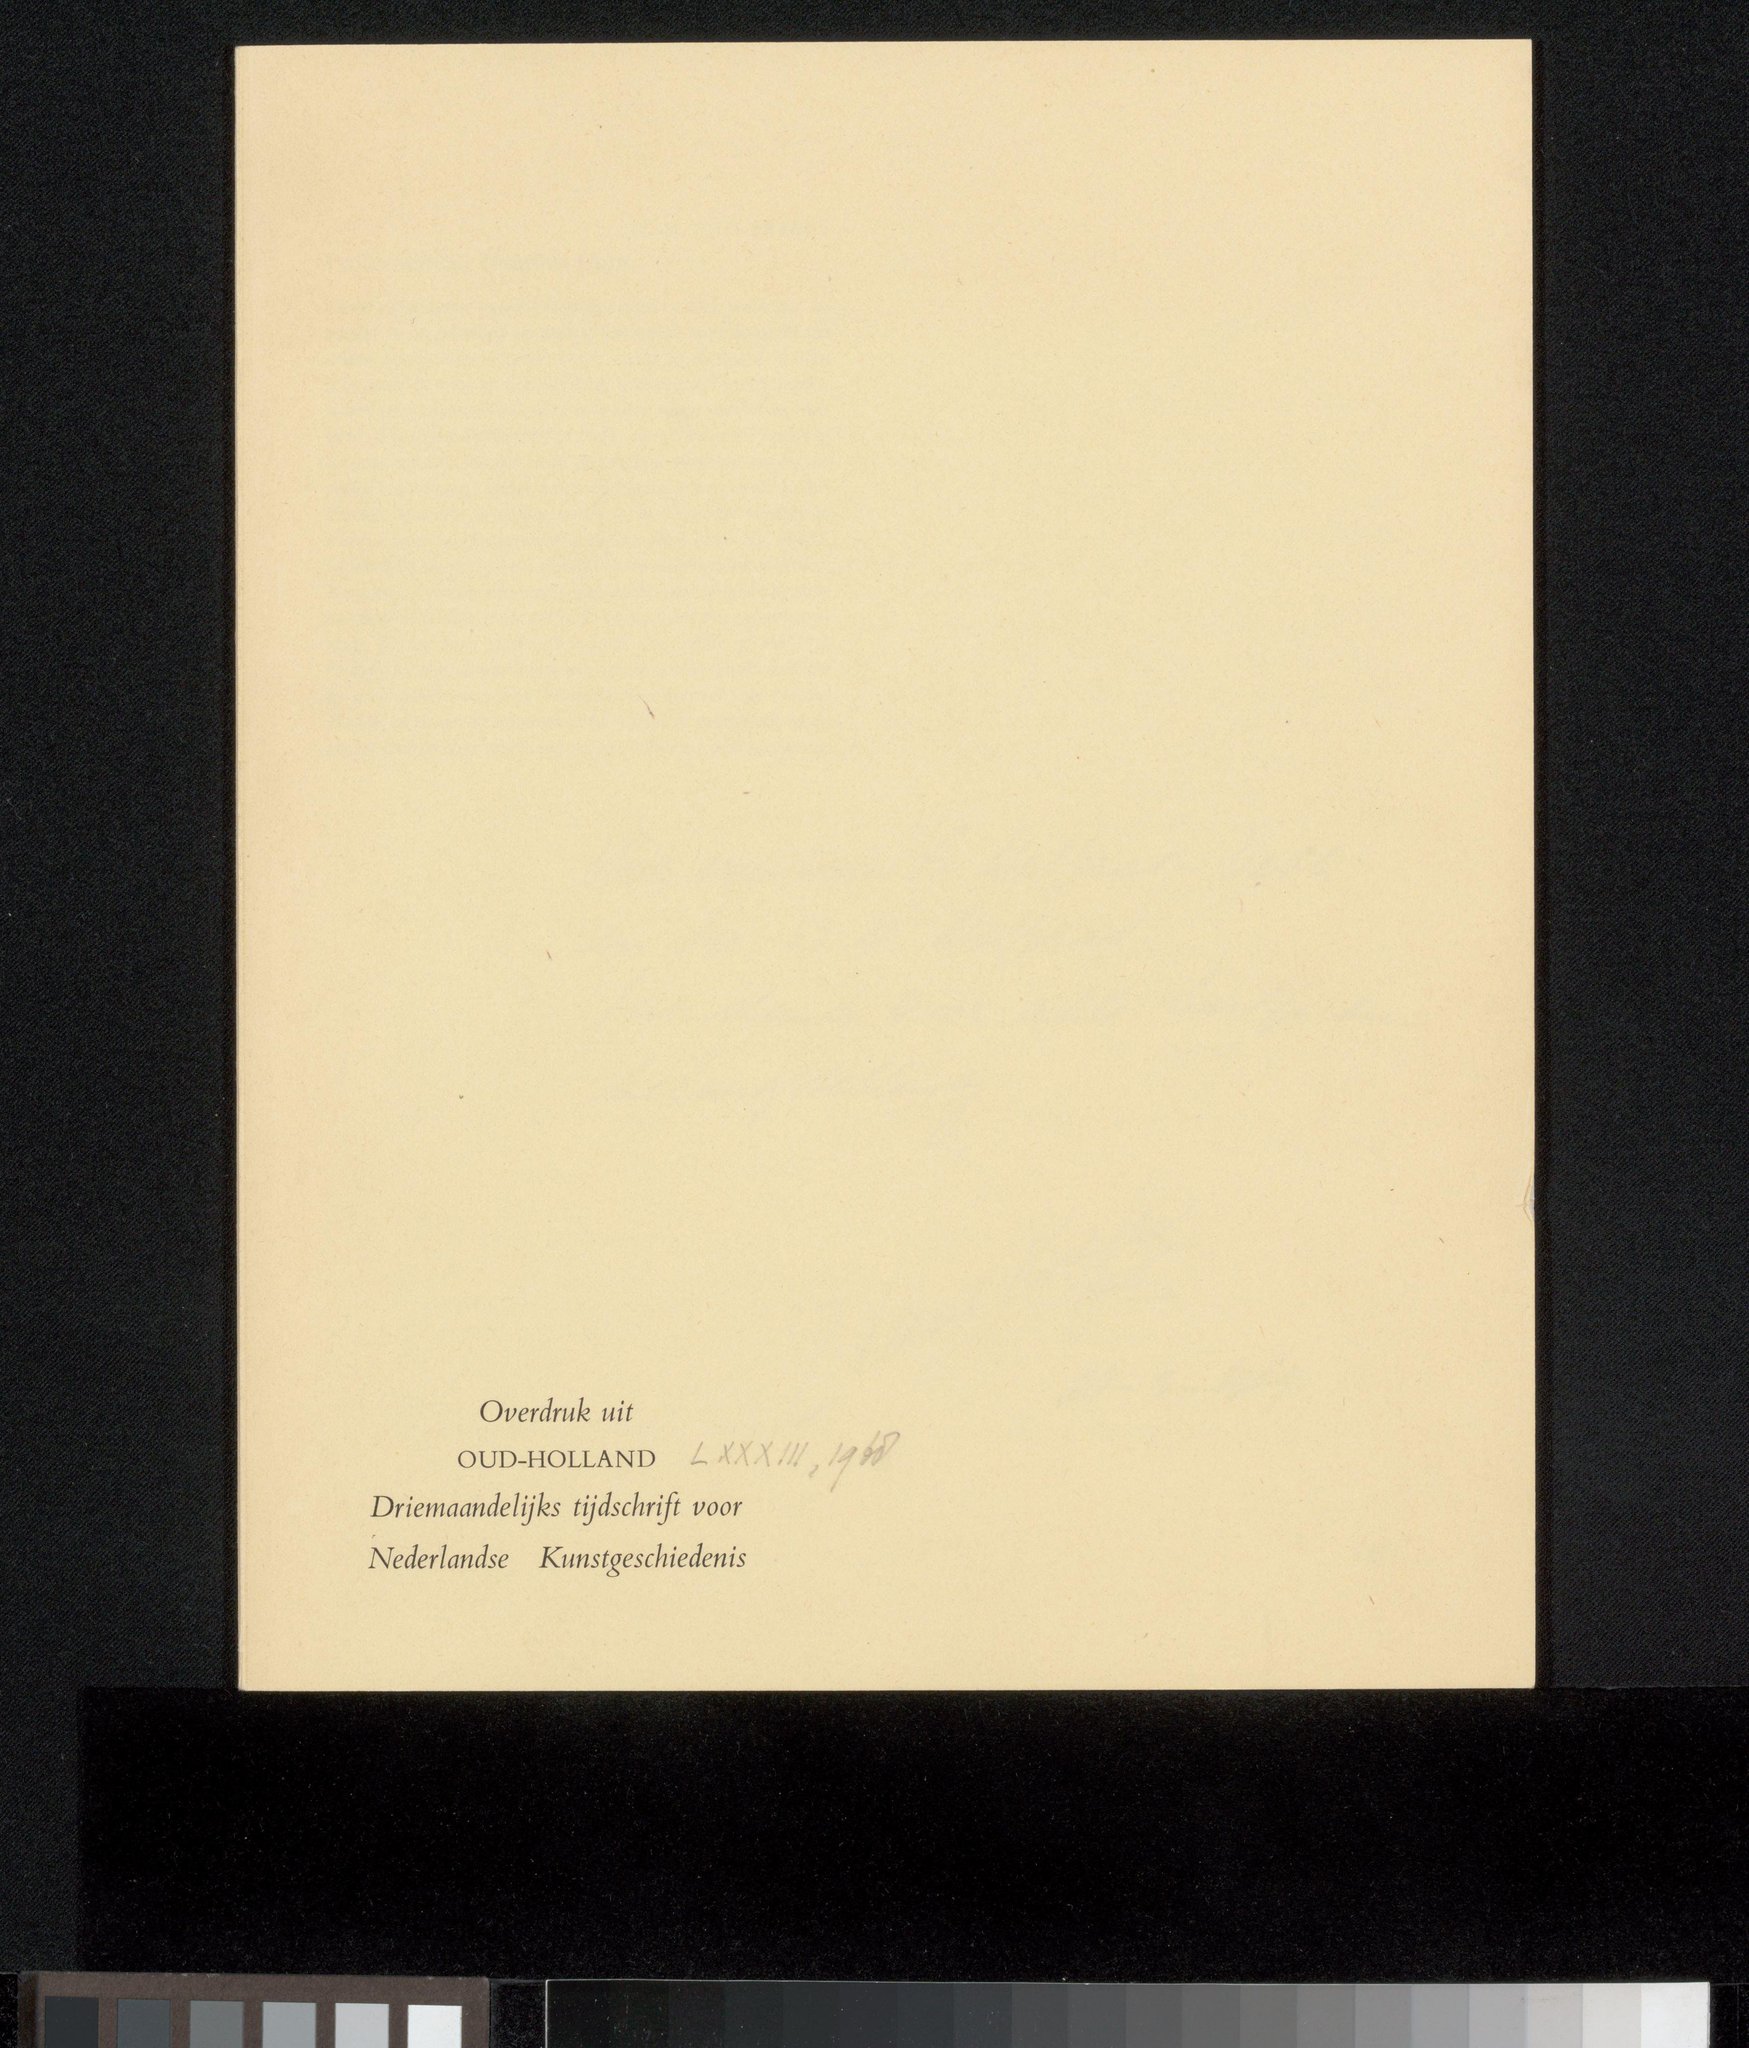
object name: article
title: Artikel uit archief Jan Veth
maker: paul kuyer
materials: paper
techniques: pen, printing, writing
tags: the hague, painter, print maker, draughtsman, johannes bosboom, amsterdam, saskia delprat-veth, daniel apollonius delprat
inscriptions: collector's mark: ‘RPK’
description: Overdruk van Paul Kuyer, "Bosbooms laatste levensjaren, Brieven van Johannes Bosboom uit de jaren 1886 tot 1891", in: Oud Holland 83 (1968), pp. 190-210.